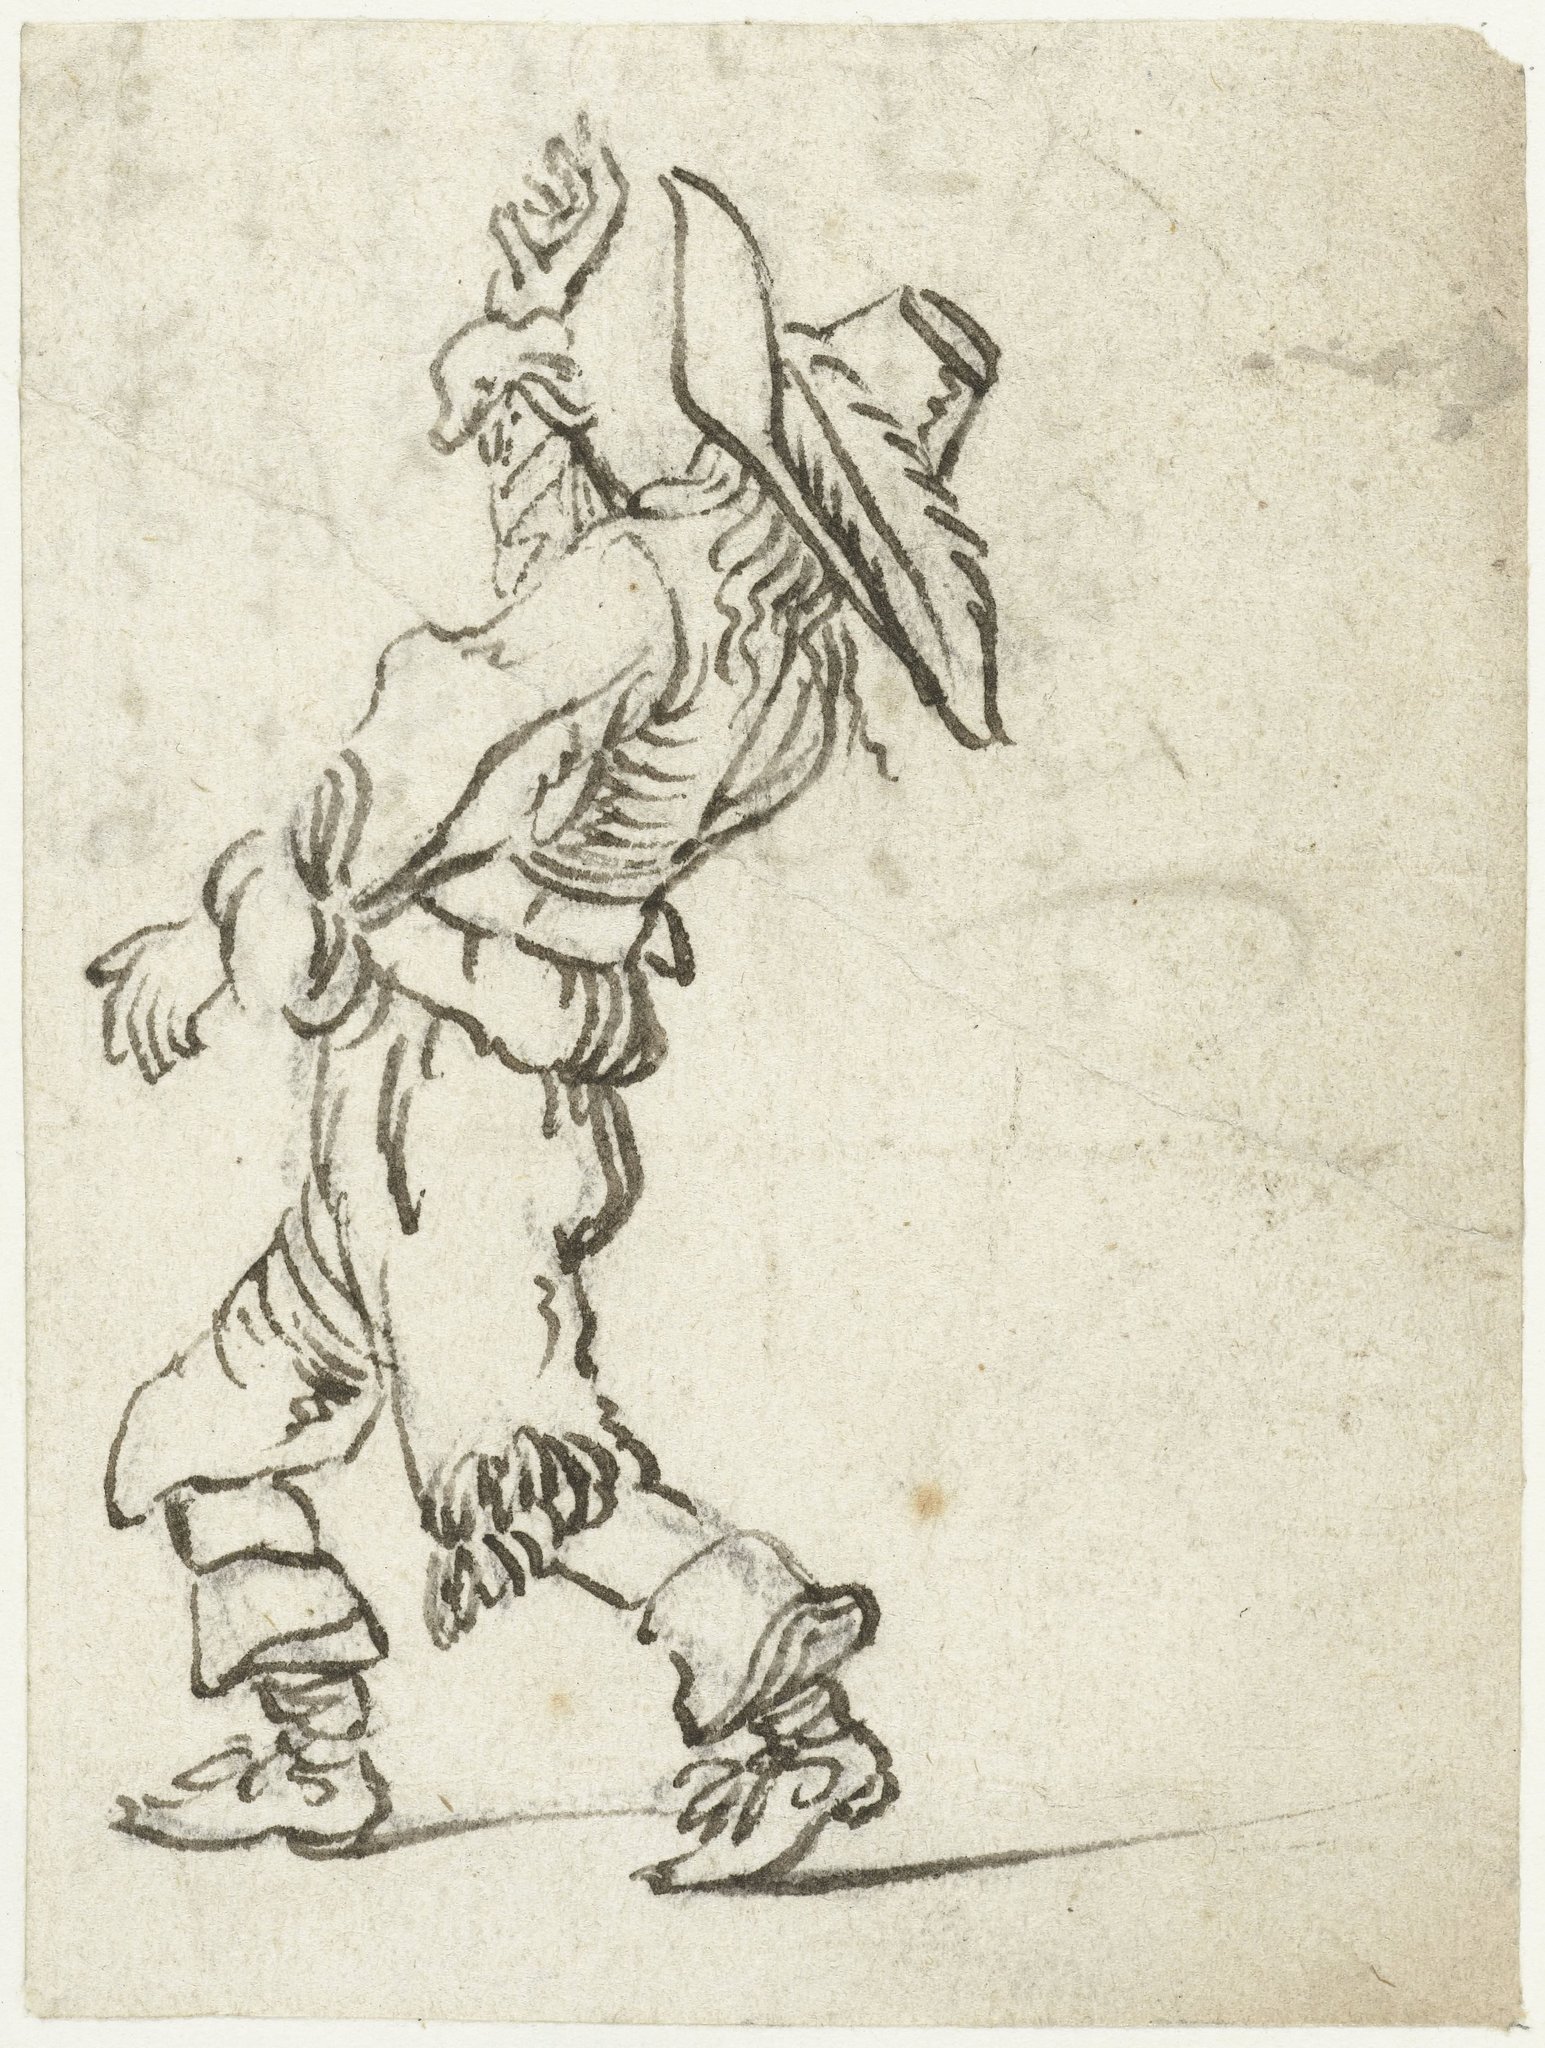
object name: drawing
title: Gooiende man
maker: gesina ter borch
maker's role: draughtsman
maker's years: 1633-1690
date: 1653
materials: chalk, ink, paper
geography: zwolle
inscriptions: inscription: ‘fragment van een rekening of declaratie’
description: Voorstudie voor een illustratie in het Poëziealbum, folio 19.